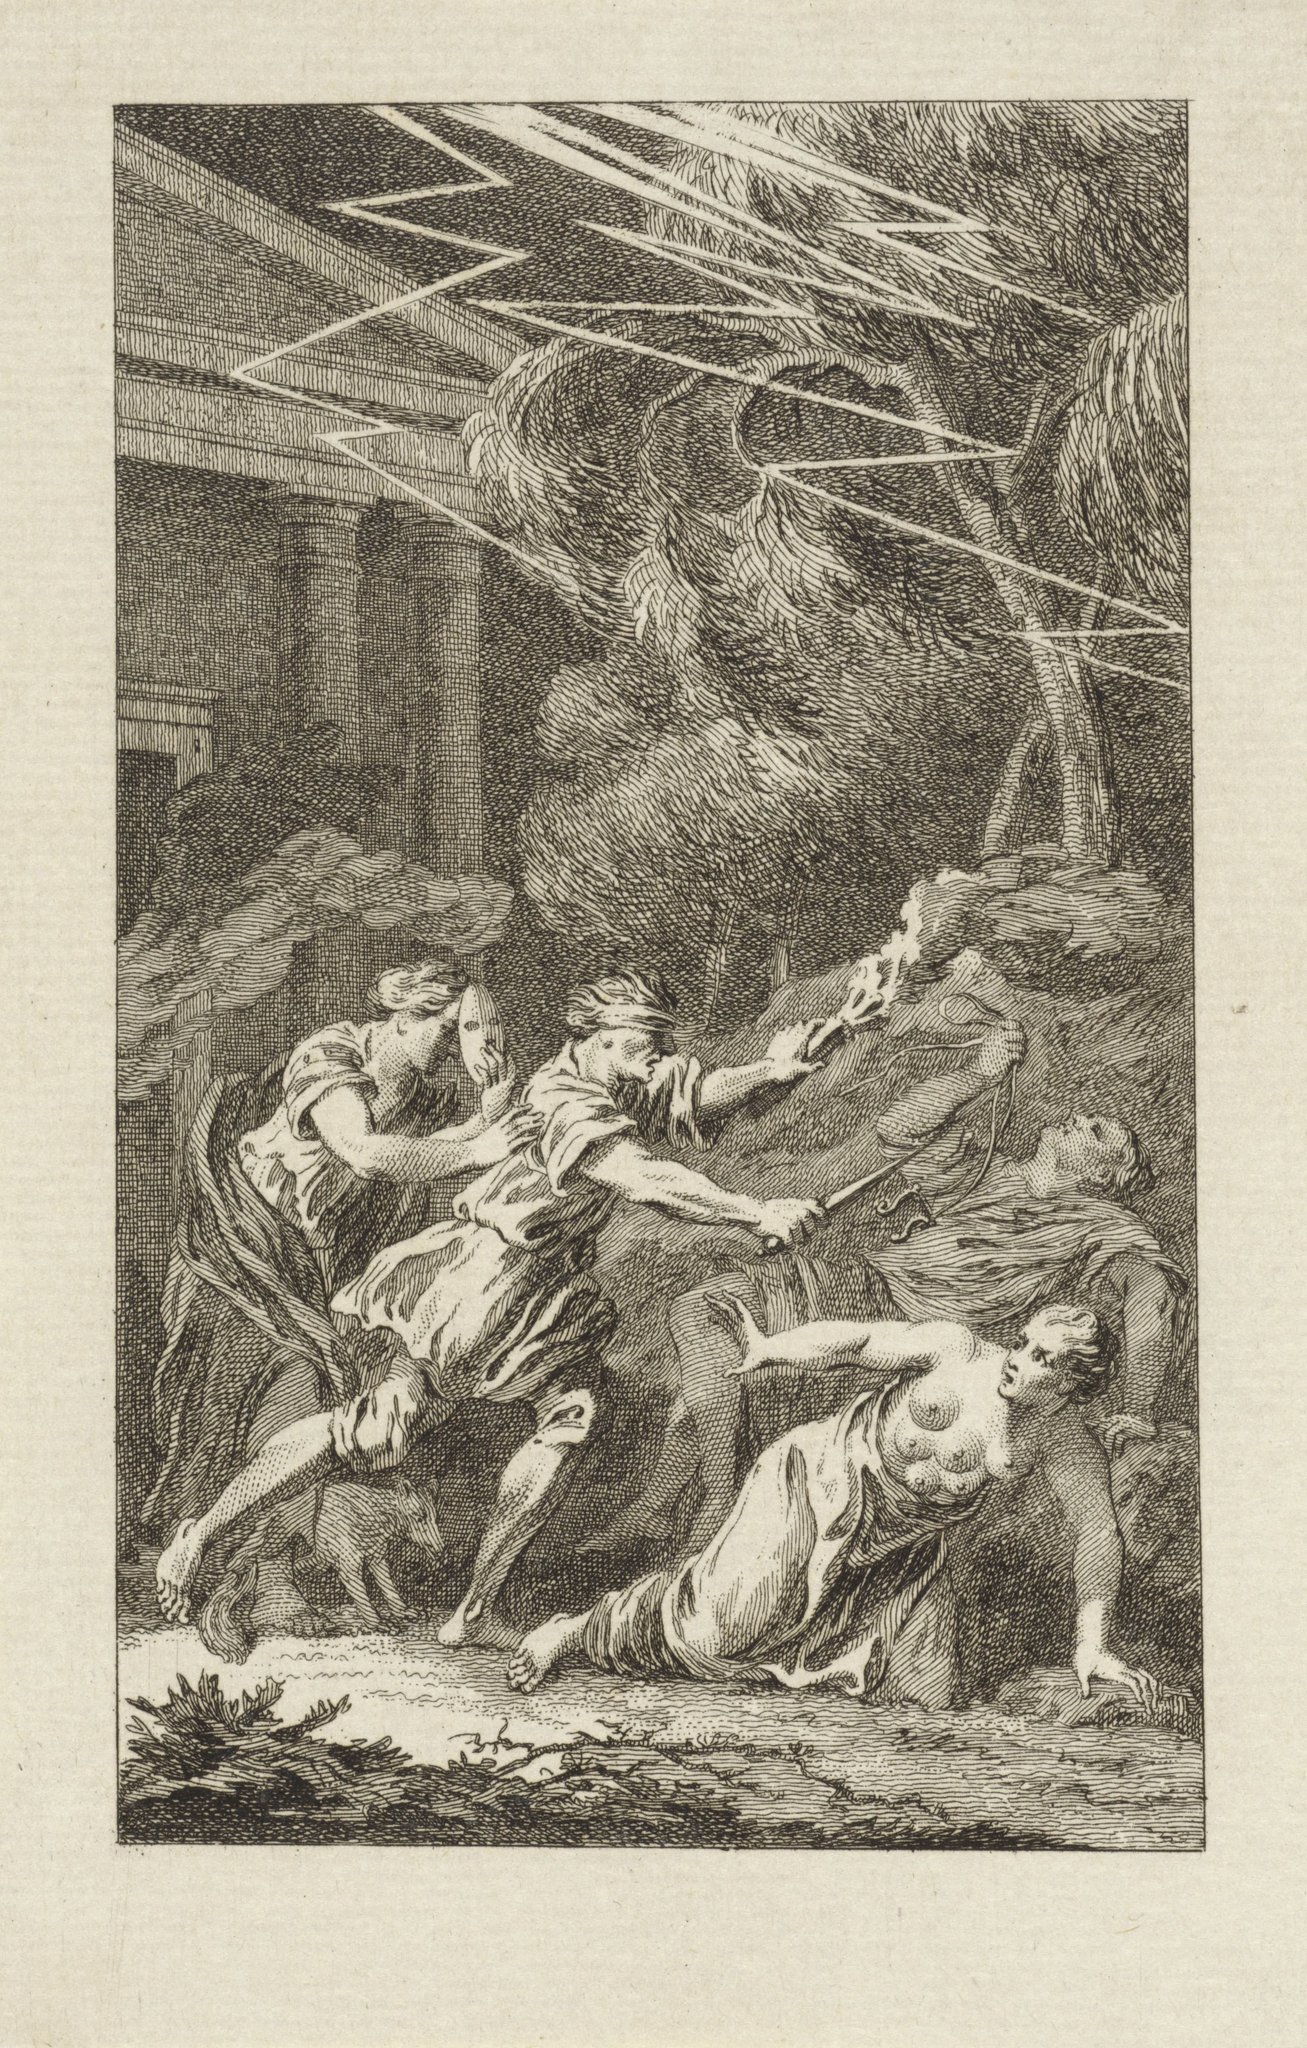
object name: print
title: Allegorie op de uitwerking van bijgeloof en huichelarij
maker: reinier vinkeles (i)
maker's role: draughtsman, print maker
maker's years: 1741-1816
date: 1770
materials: paper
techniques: engraving, etching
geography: amsterdam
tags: mask, 'superstitione' (ripa), lightning, flash of lightning, thunderbolt, rage, anger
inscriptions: collector's mark: Lugt 240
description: De personificaties van Natuur en Rede worden onder de voet gelopen door een geblinddoekte man met dolk en toorts. De man wordt voortgeduwd door een vrouw die zich achter een masker verschuilt.